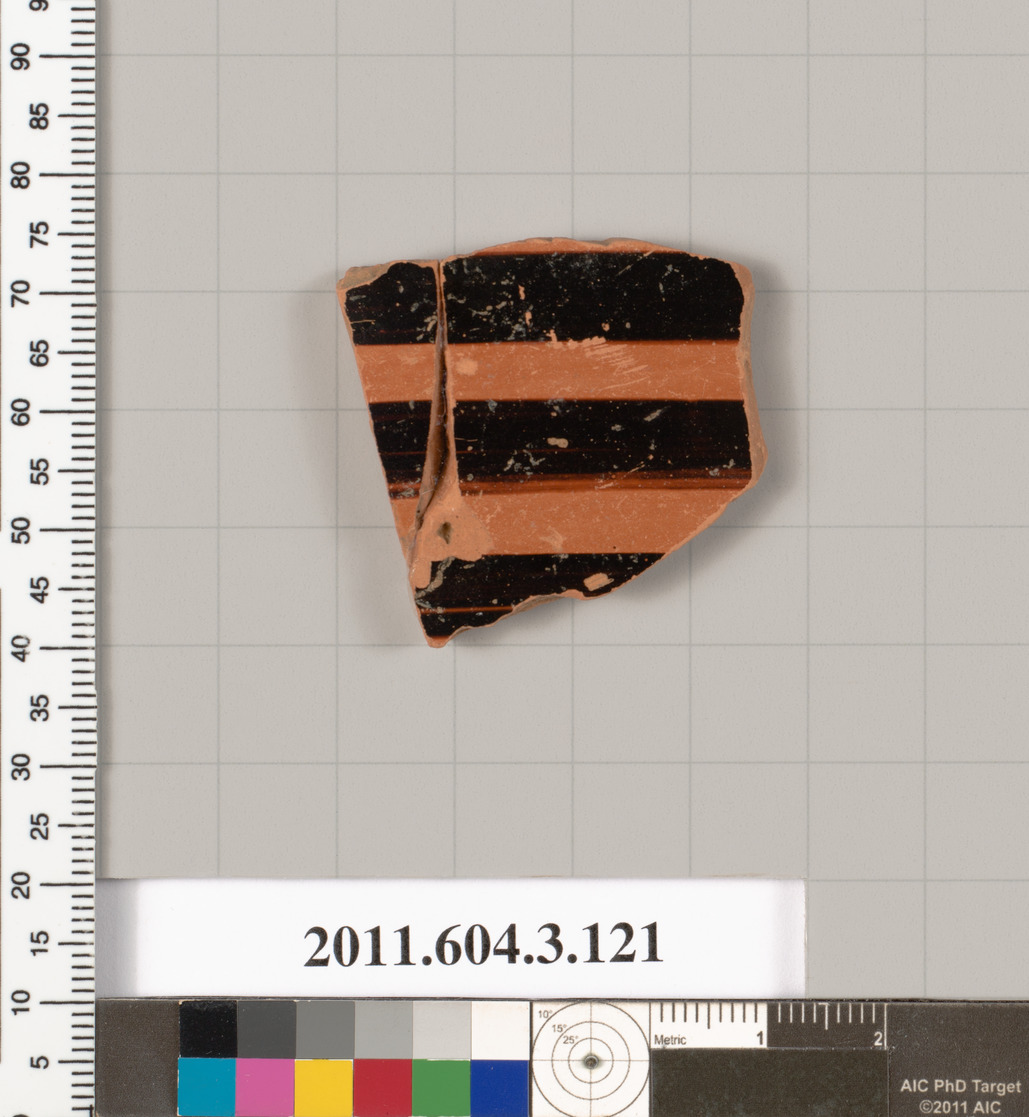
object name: amphora fragment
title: Terracotta fragment of an amphora (jar)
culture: greek, attic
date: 534-501 BCE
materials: terracotta